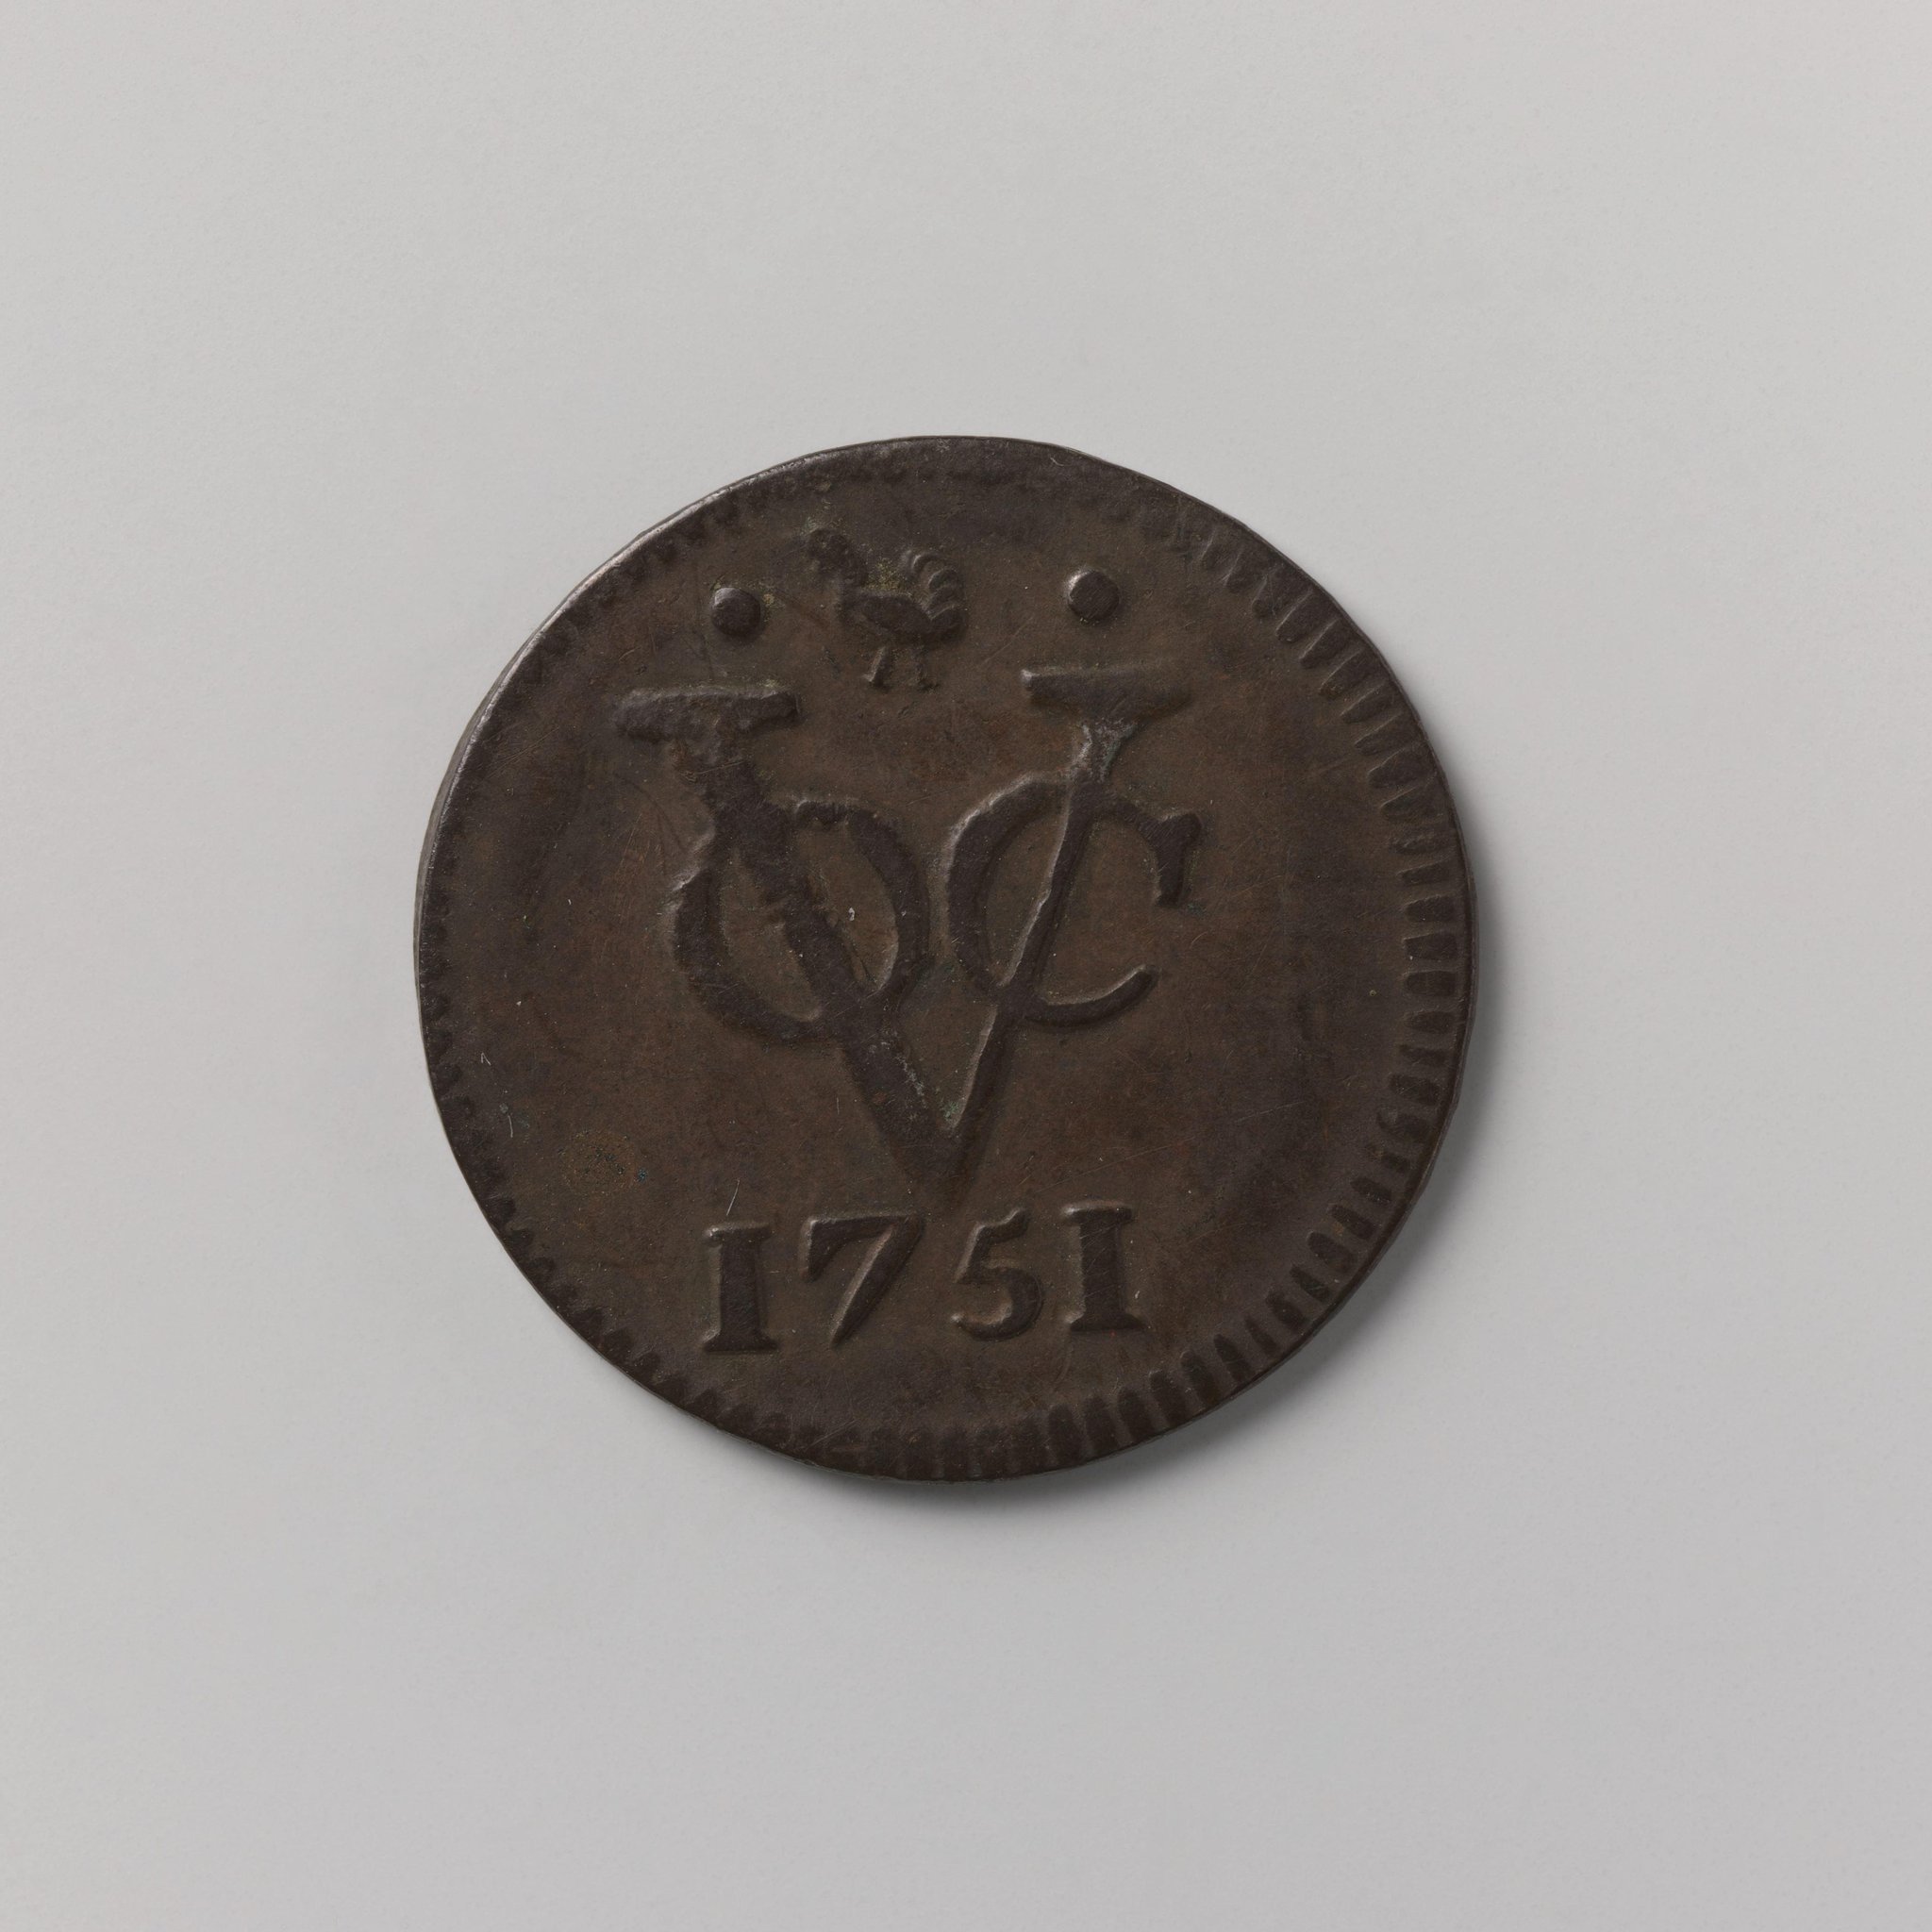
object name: coin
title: Duit van de VOC uit Westfriesland, 1751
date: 1751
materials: copper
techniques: striking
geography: medemblik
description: Koperen munt. Voorzijde: gekroond wapenschild van Westfriesland. Keerzijde: monogram van de VOC, waarboven muntmeesterteken en waaronder jaartal. Gladde rand.